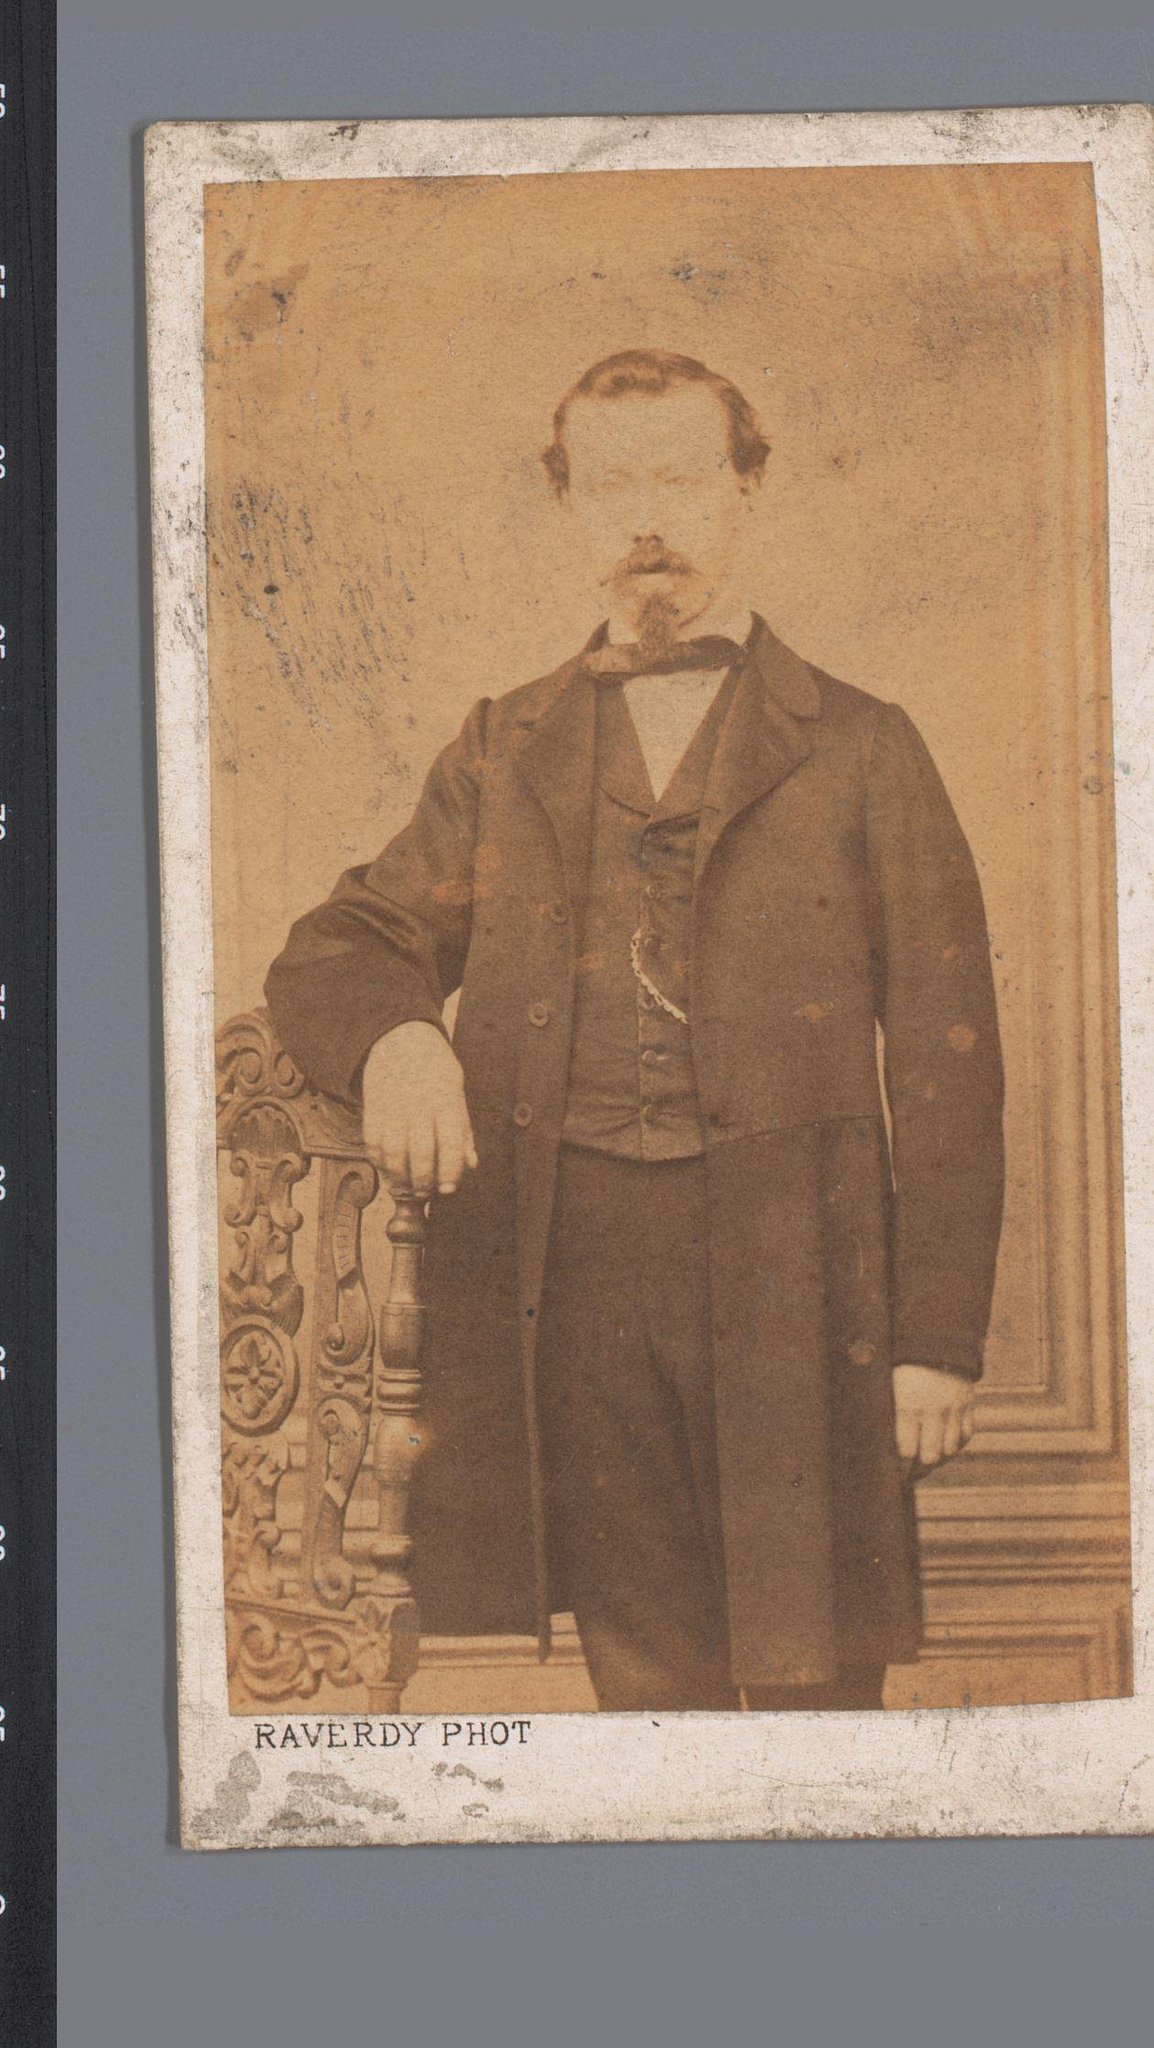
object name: carte de visite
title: Portret van een onbekende man bij een stoel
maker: raverdy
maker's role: fotograaf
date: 1855-1885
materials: cardboard, paper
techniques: albumen print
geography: valenciennes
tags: adult man, anonymous historical person portrayed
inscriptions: address: ‘23, rue St. Géry, 23/ VALENCIENNES’